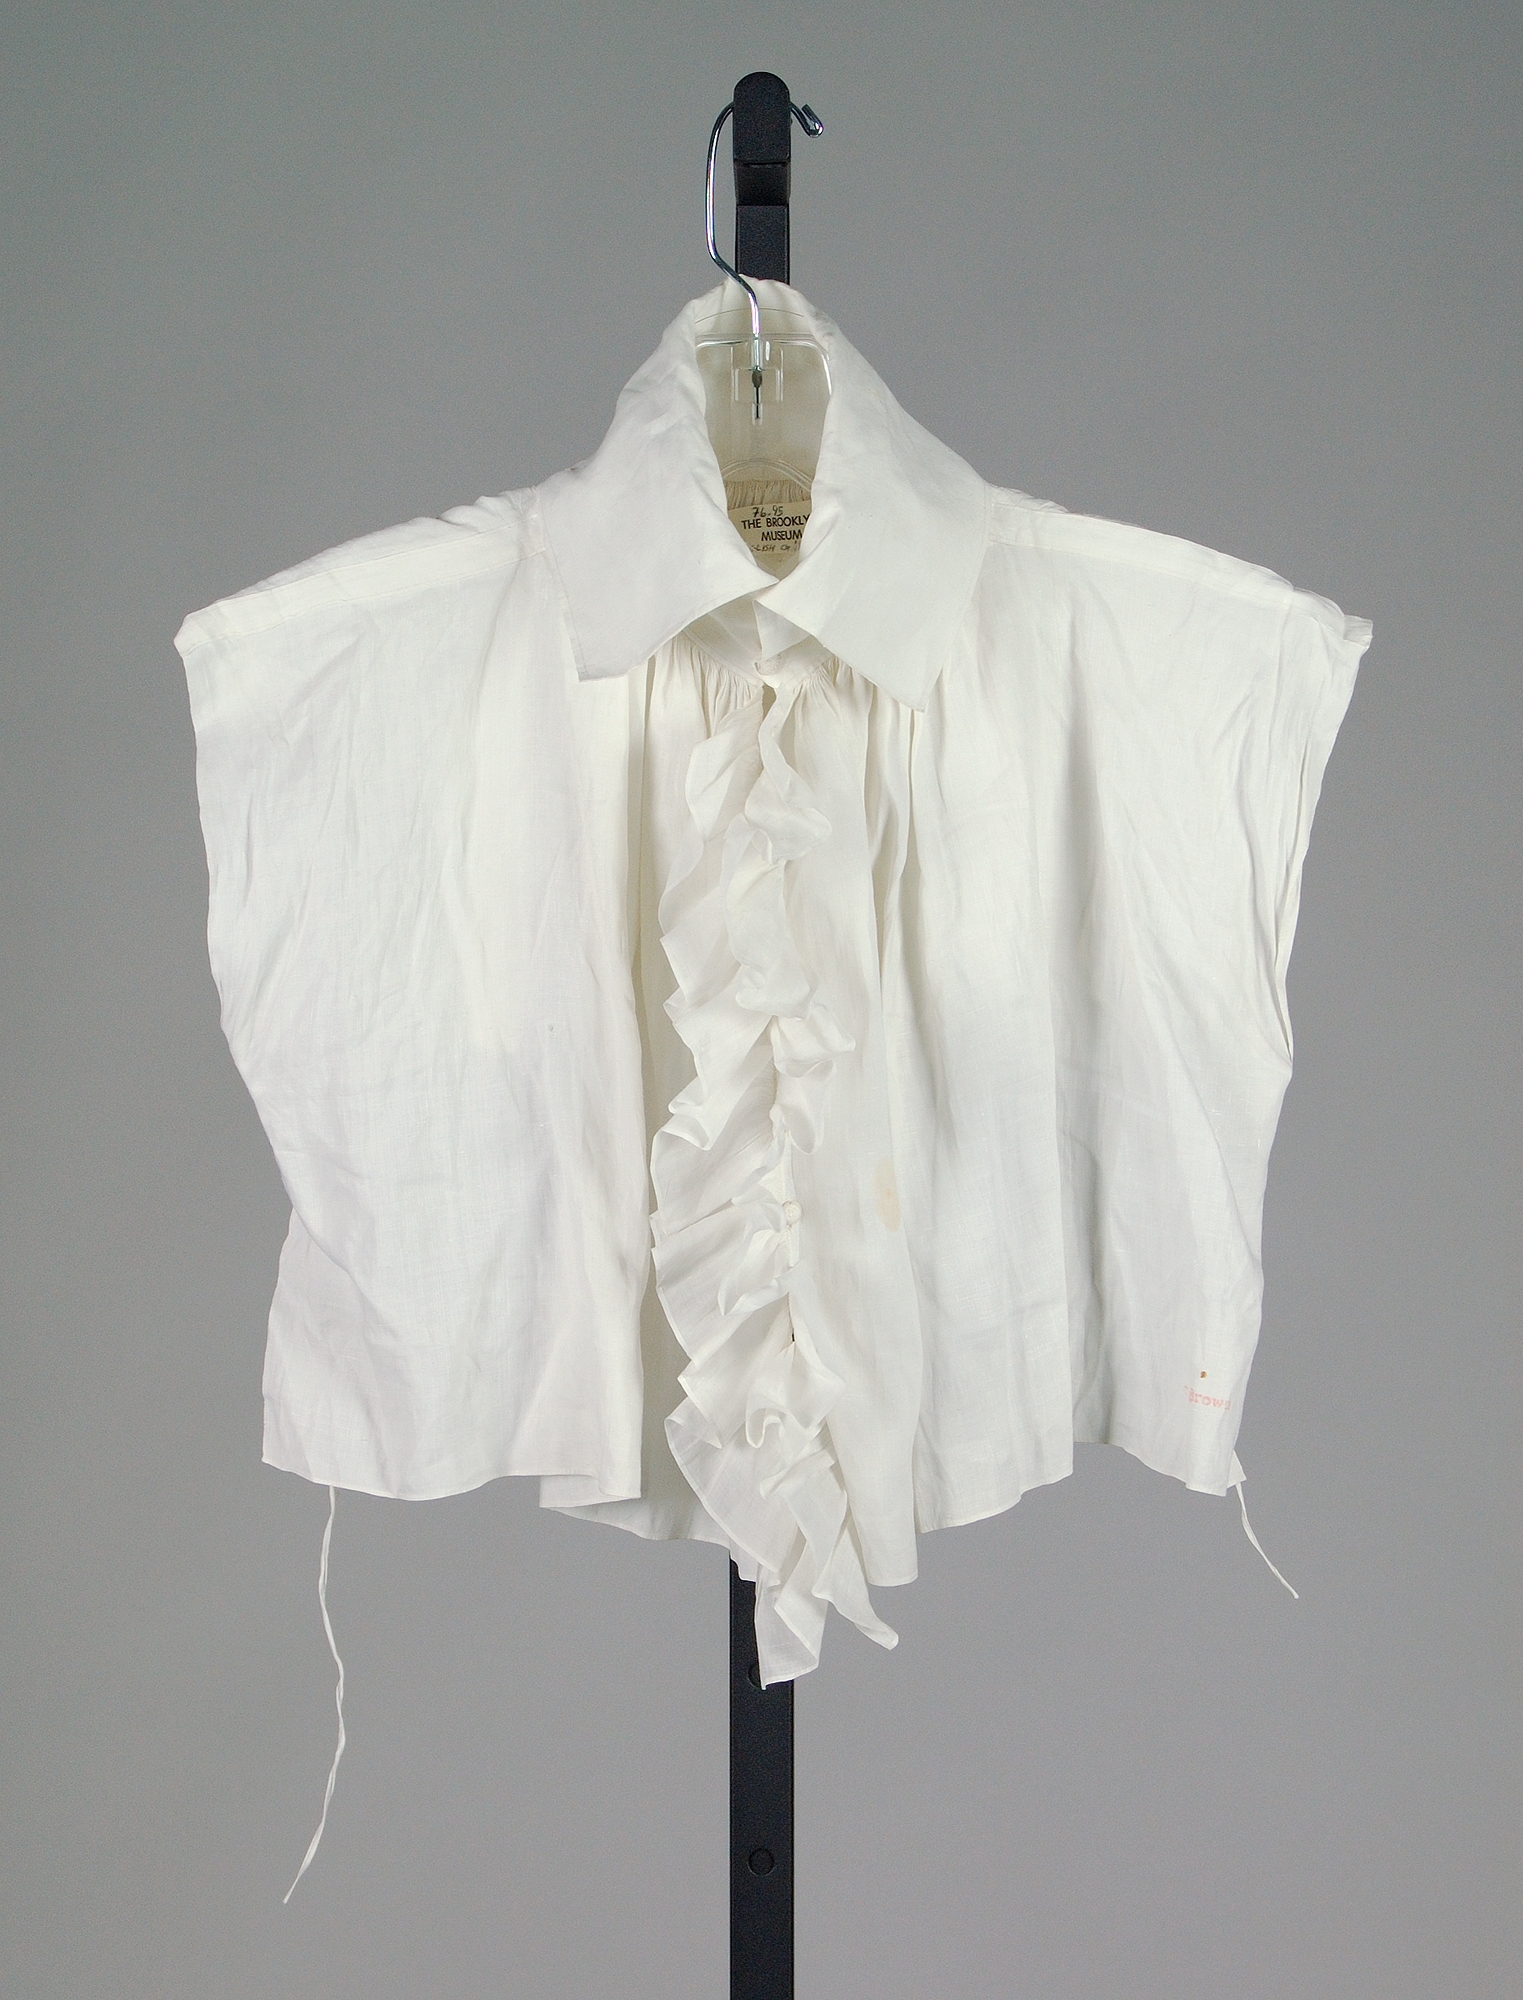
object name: chemise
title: Chemisette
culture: british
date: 1790-1805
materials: linen